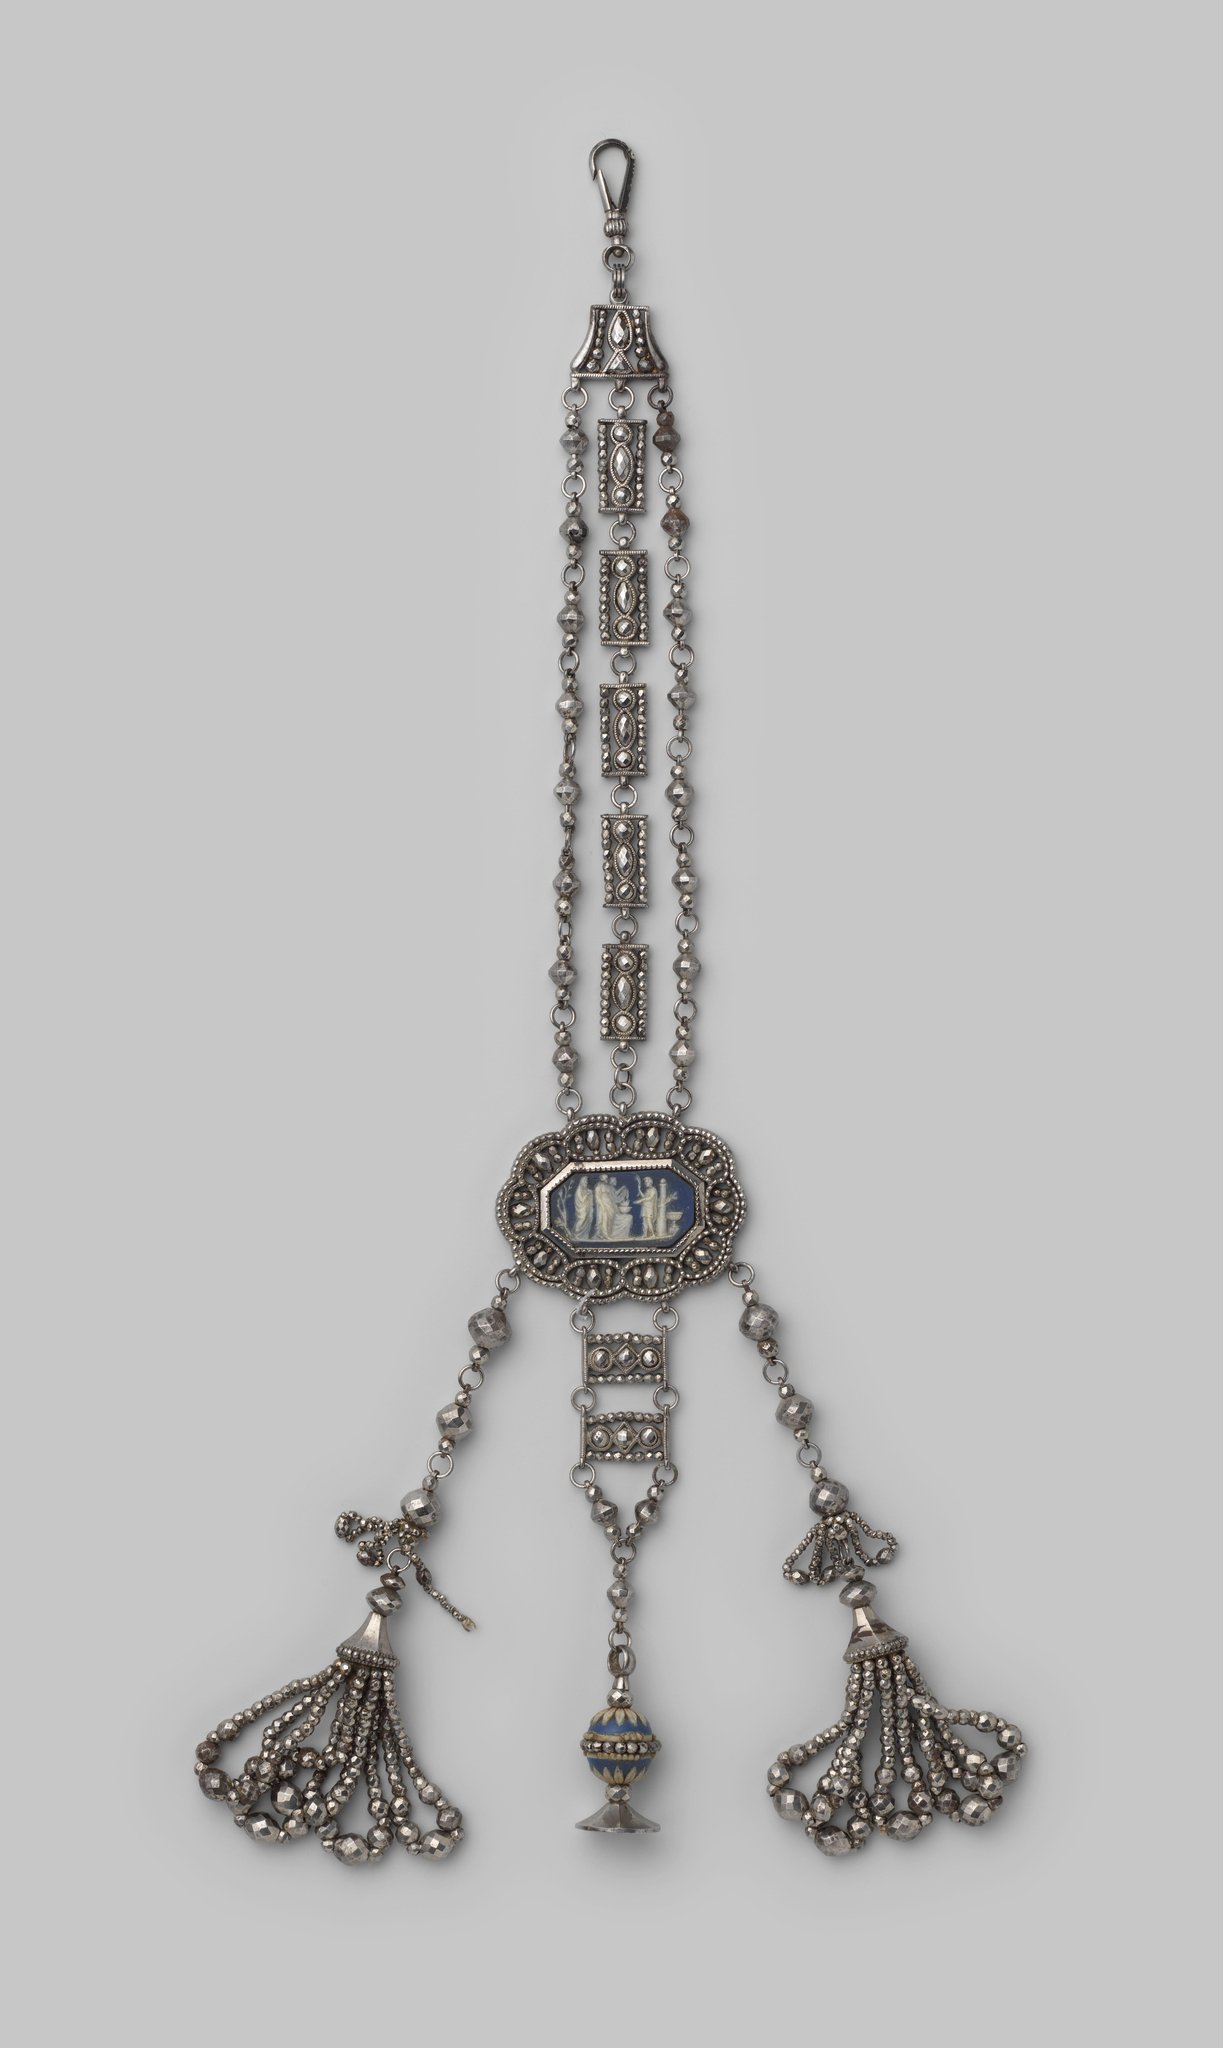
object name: chatelaine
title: Horlogeketting van staal met Wedgwood medaillon in wit en blauw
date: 1790-1810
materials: steel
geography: birmingham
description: Horlogeketting van staal (acier découpé). Bestaande uit drie kettingen, waarvan de buitenste gevormd worden door een aaneenschakeling van drie aan elkaar gesneden kralen en de middelste door vijf rechthoeken met gesneden ornamenten. Hieraan hangt een geschulpt medaillon met reliëf van steengoed in wit en blauw (Wedgwood). De ene zijde vertoont (?) en twee leeuwen; de andere zijde klassieke figuren voor een altaar met brandend vuur. Aan dit medaillon hangen kettingen waarvan twee eindigen in stalen kwasten en de middelste in een cachet.